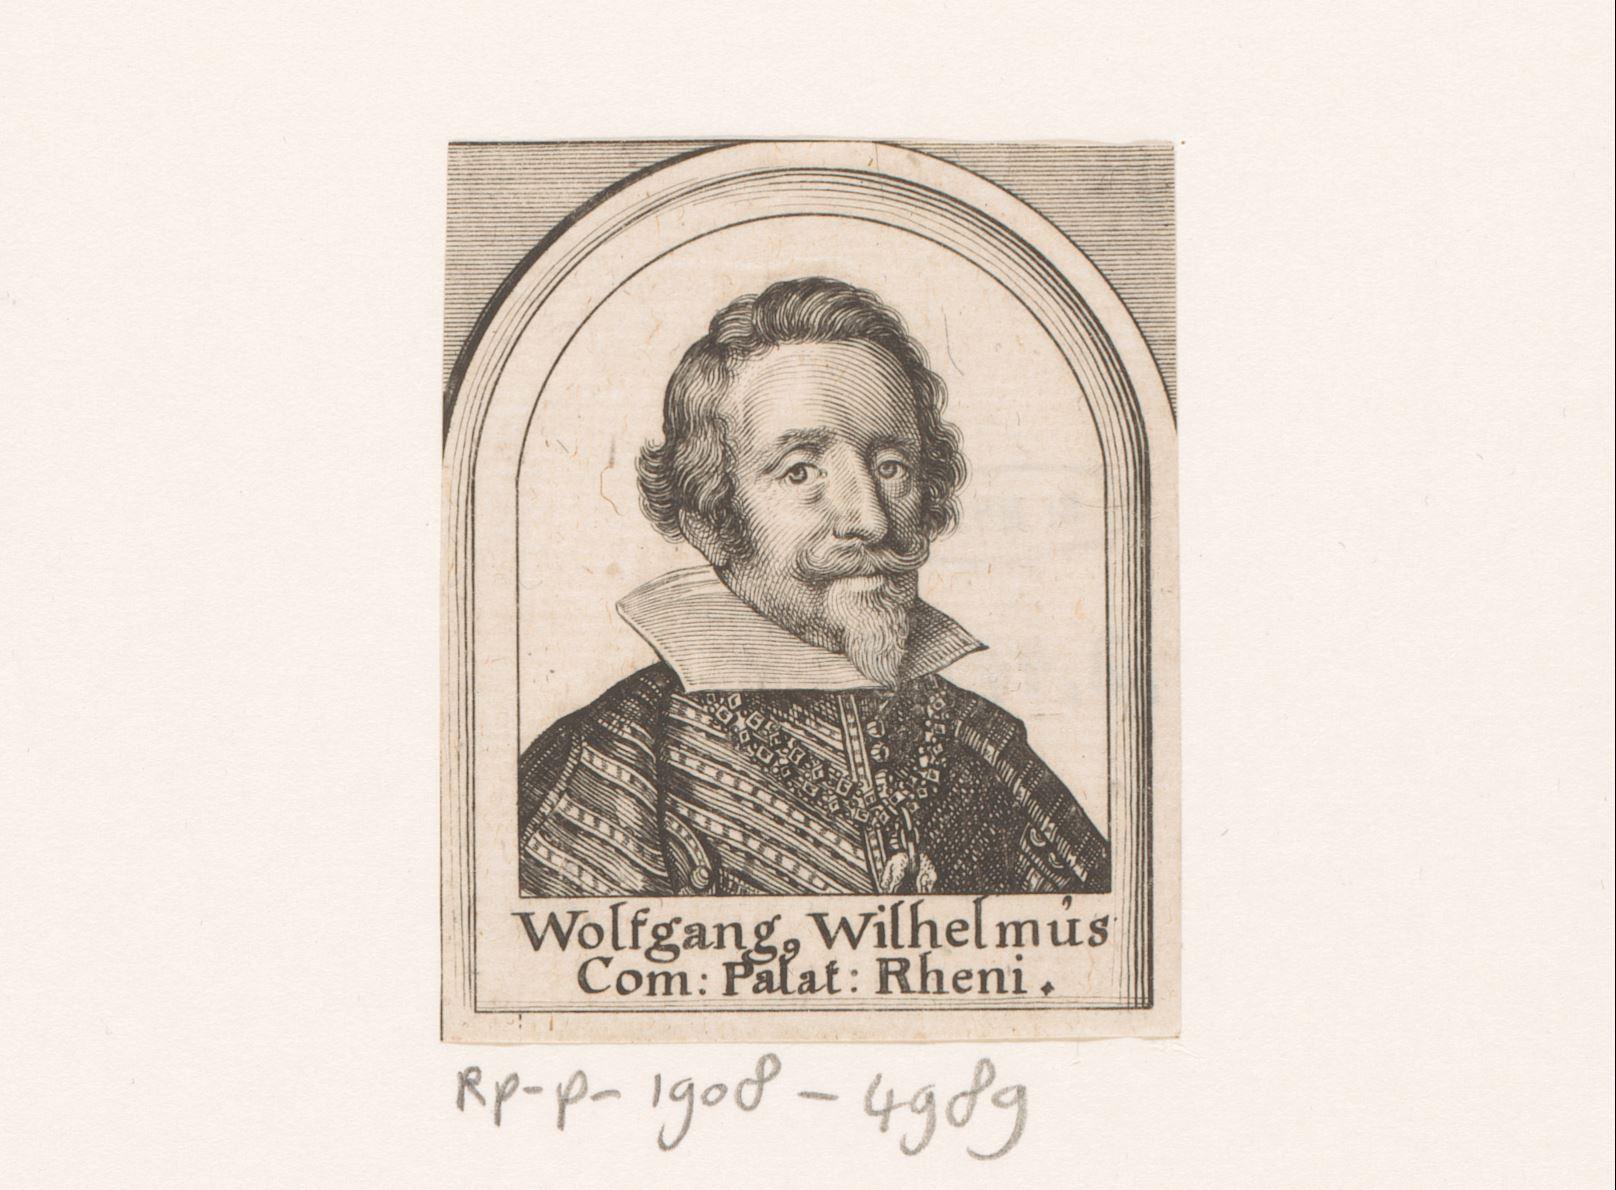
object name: print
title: Portret van Wolfgang Willem van de Palts-Neuburg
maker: matthäus merian (i)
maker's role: print maker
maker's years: 1593-1650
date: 1603-1650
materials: paper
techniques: engraving, etching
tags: wolfgang willem van de palts-neuburg, historical persons, knighthood order of the golden fleece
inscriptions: collector's mark: Lugt 2228